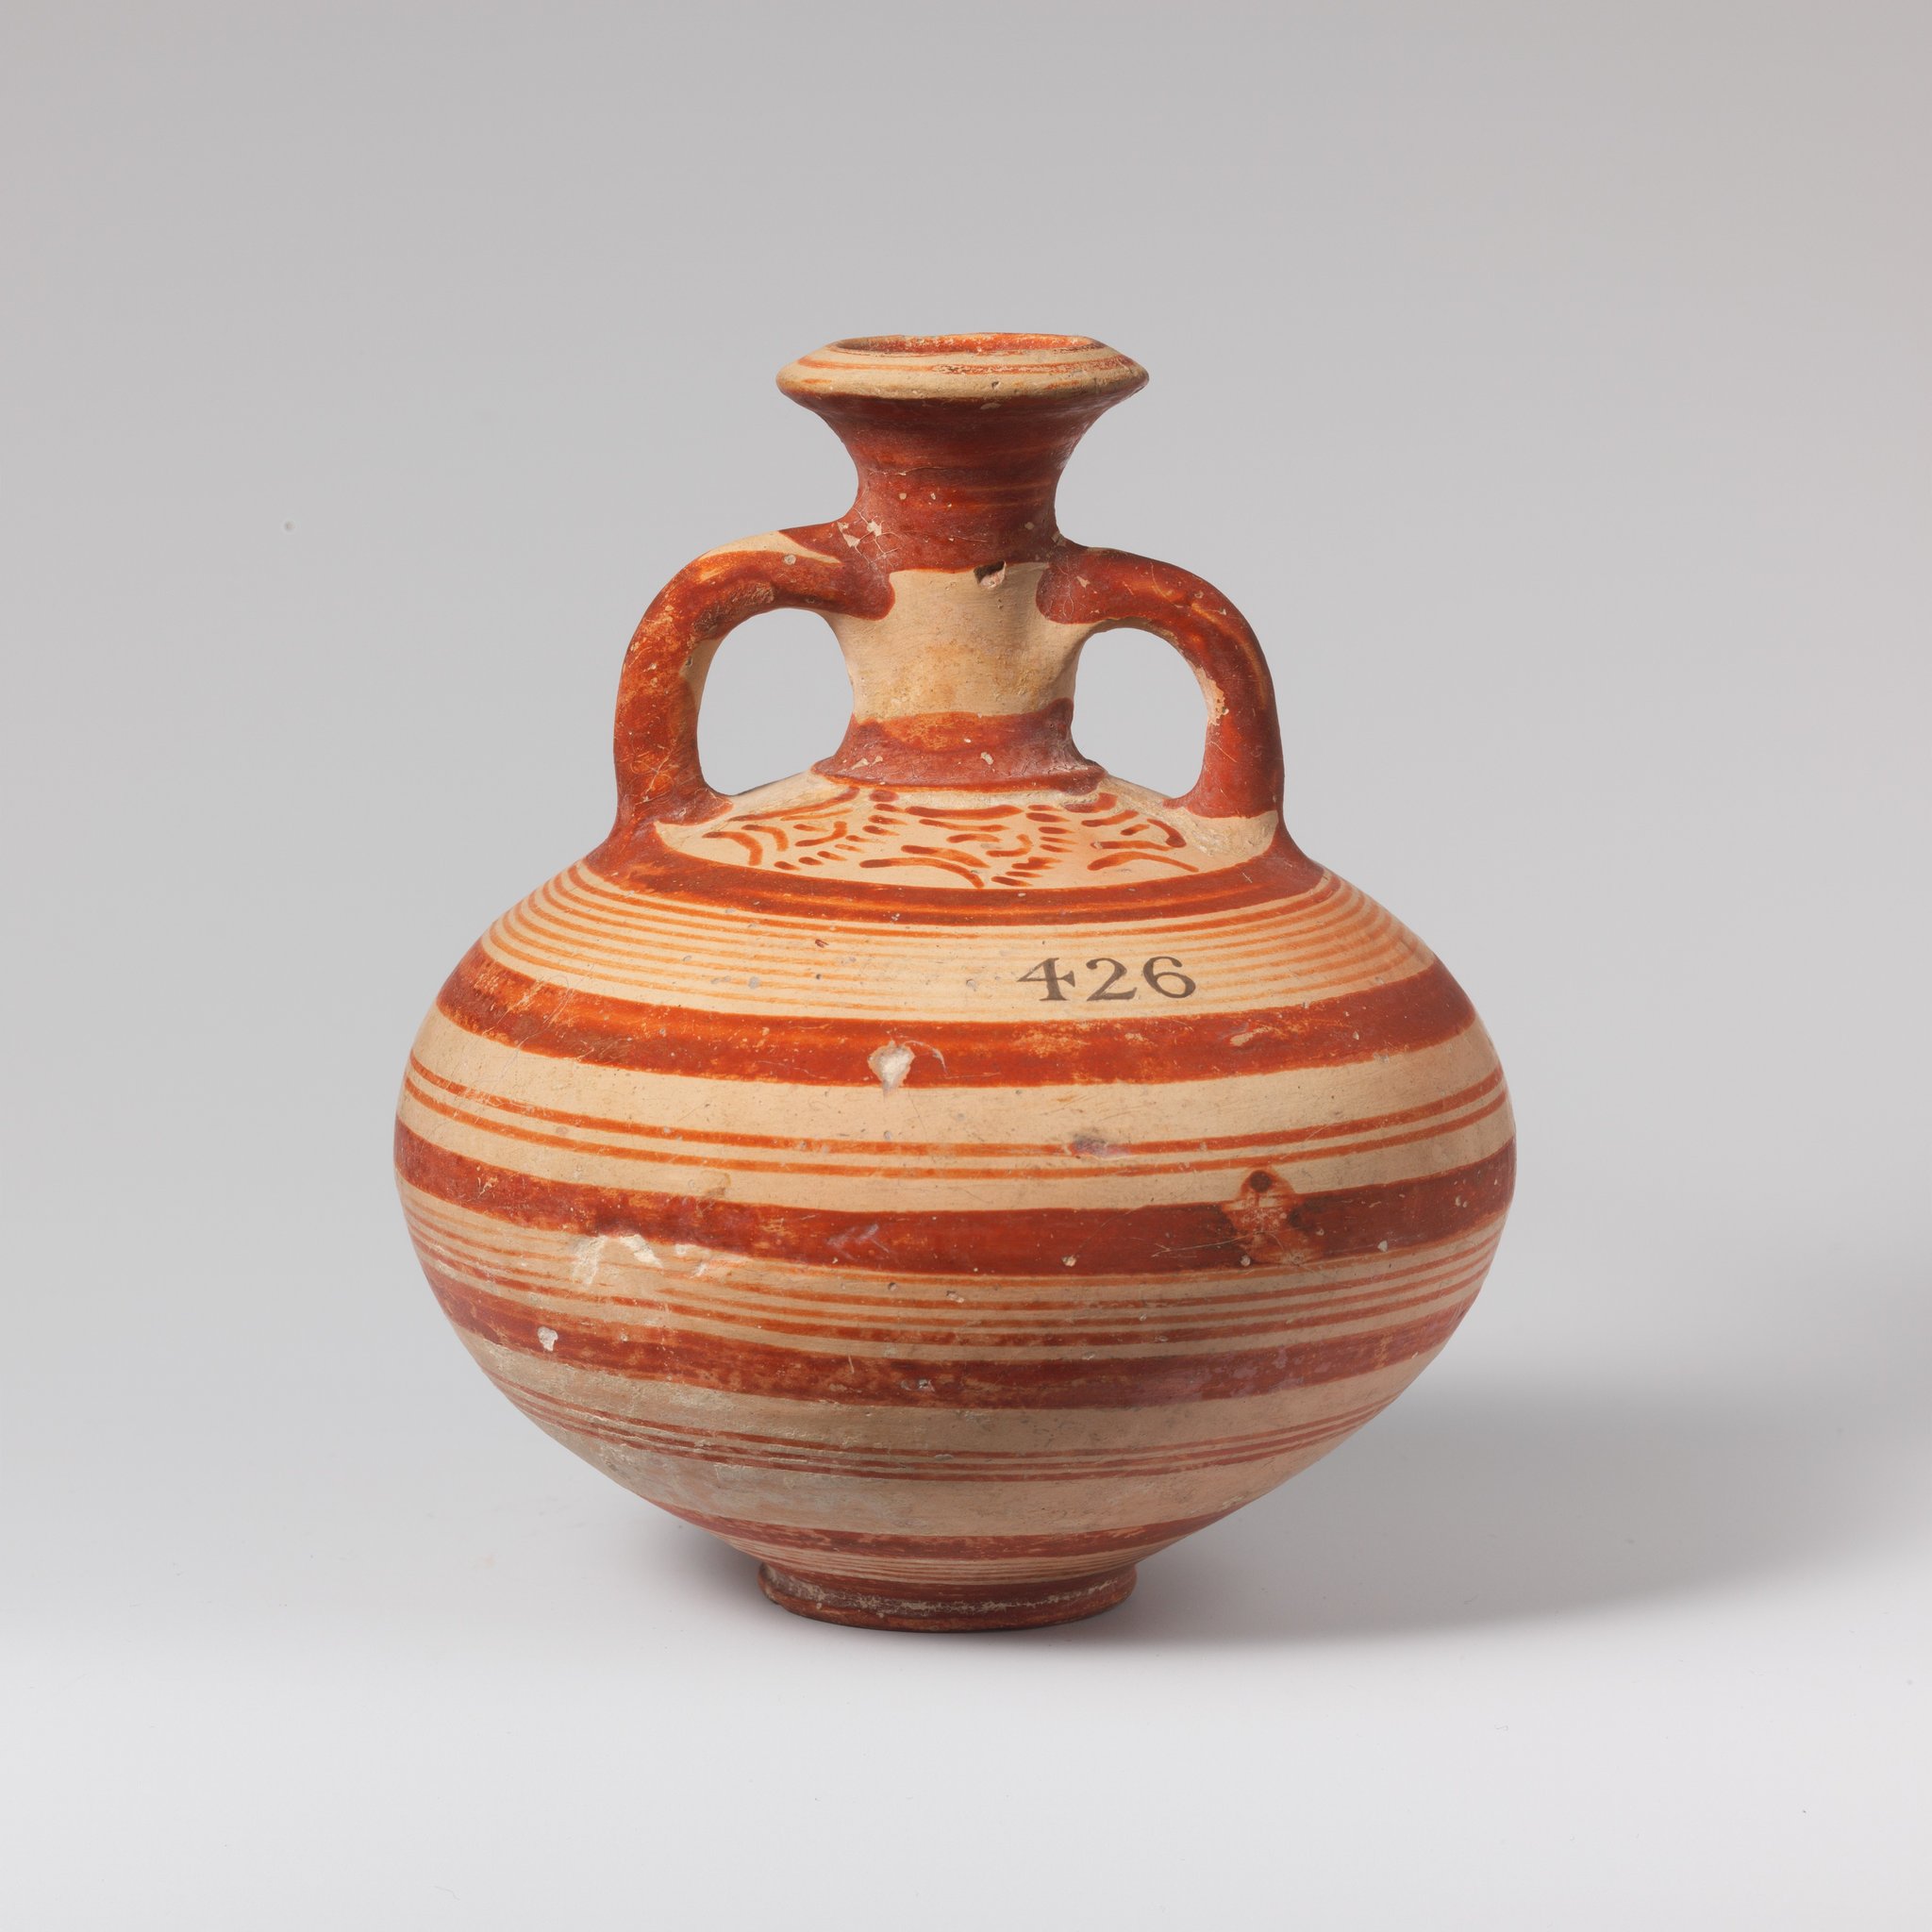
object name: vase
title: Terracotta globular flask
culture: mycenaean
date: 1400-1300 BCE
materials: terracotta